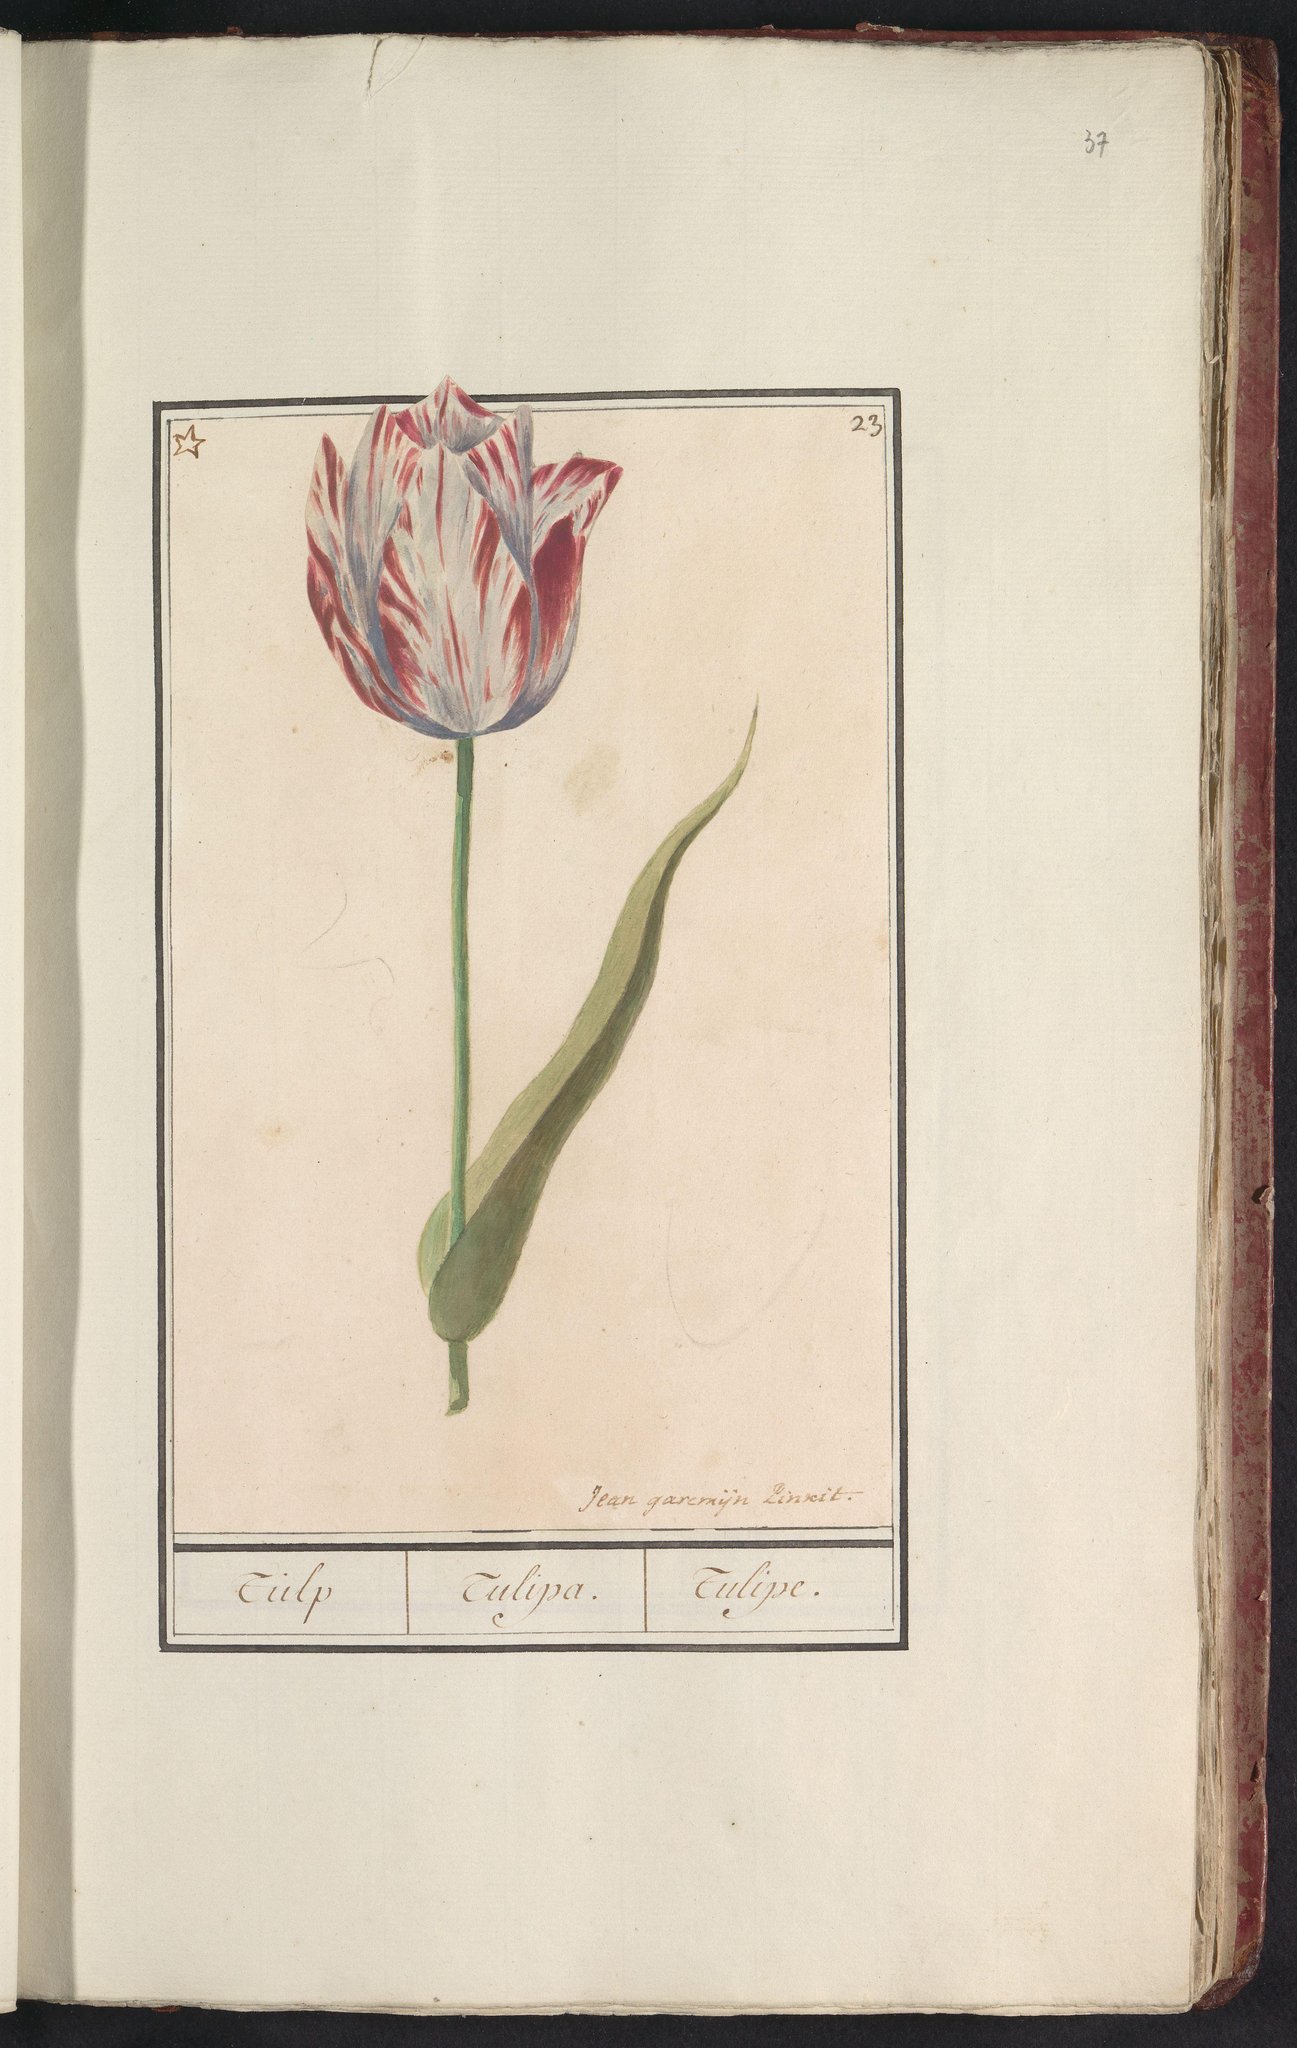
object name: drawing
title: Tulp (Tulipa)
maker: jan anton garemyn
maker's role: draughtsman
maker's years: 1712-1799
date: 1790-1799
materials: chalk, paint, paper, watercolor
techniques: brush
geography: bruges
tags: flowers: tulip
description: Rood-witte tulp. Genummerd rechtsboven: 23. Linksboven gemerkt met een sterretje. Onderdeel van het eerste album met tekeningen van bloemen en planten. Achtste van twaalf albums met tekeningen van dieren, vogels en planten bekend rond 1600, gemaakt in opdracht van keizer Rudolf II. Met toelichting in Nederlands, Latijn en Frans.